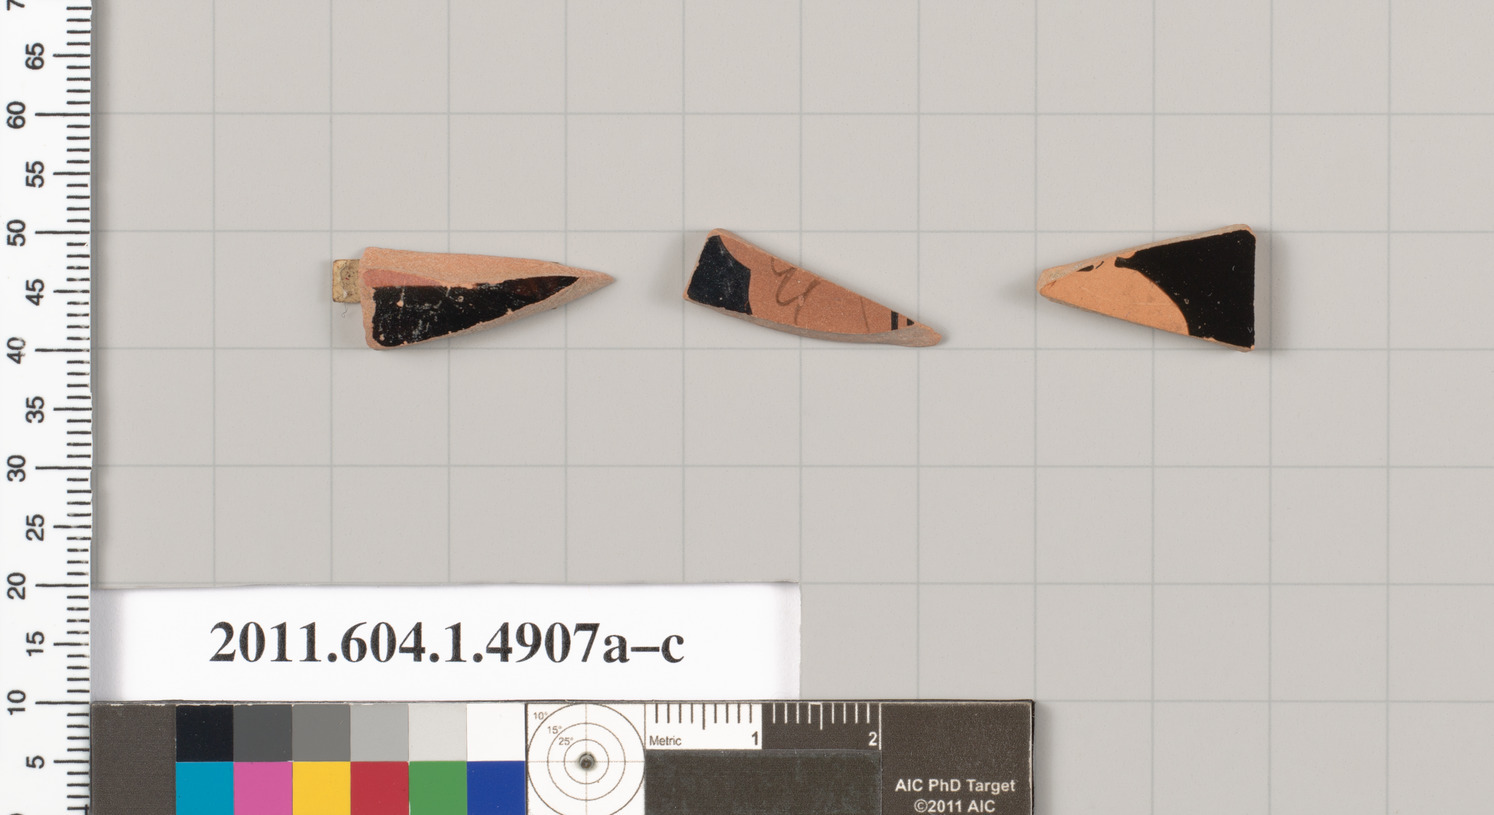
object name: kylix fragment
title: Terracotta fragments of kylikes (drinking cups)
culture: greek, attic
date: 600-401 BCE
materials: terracotta